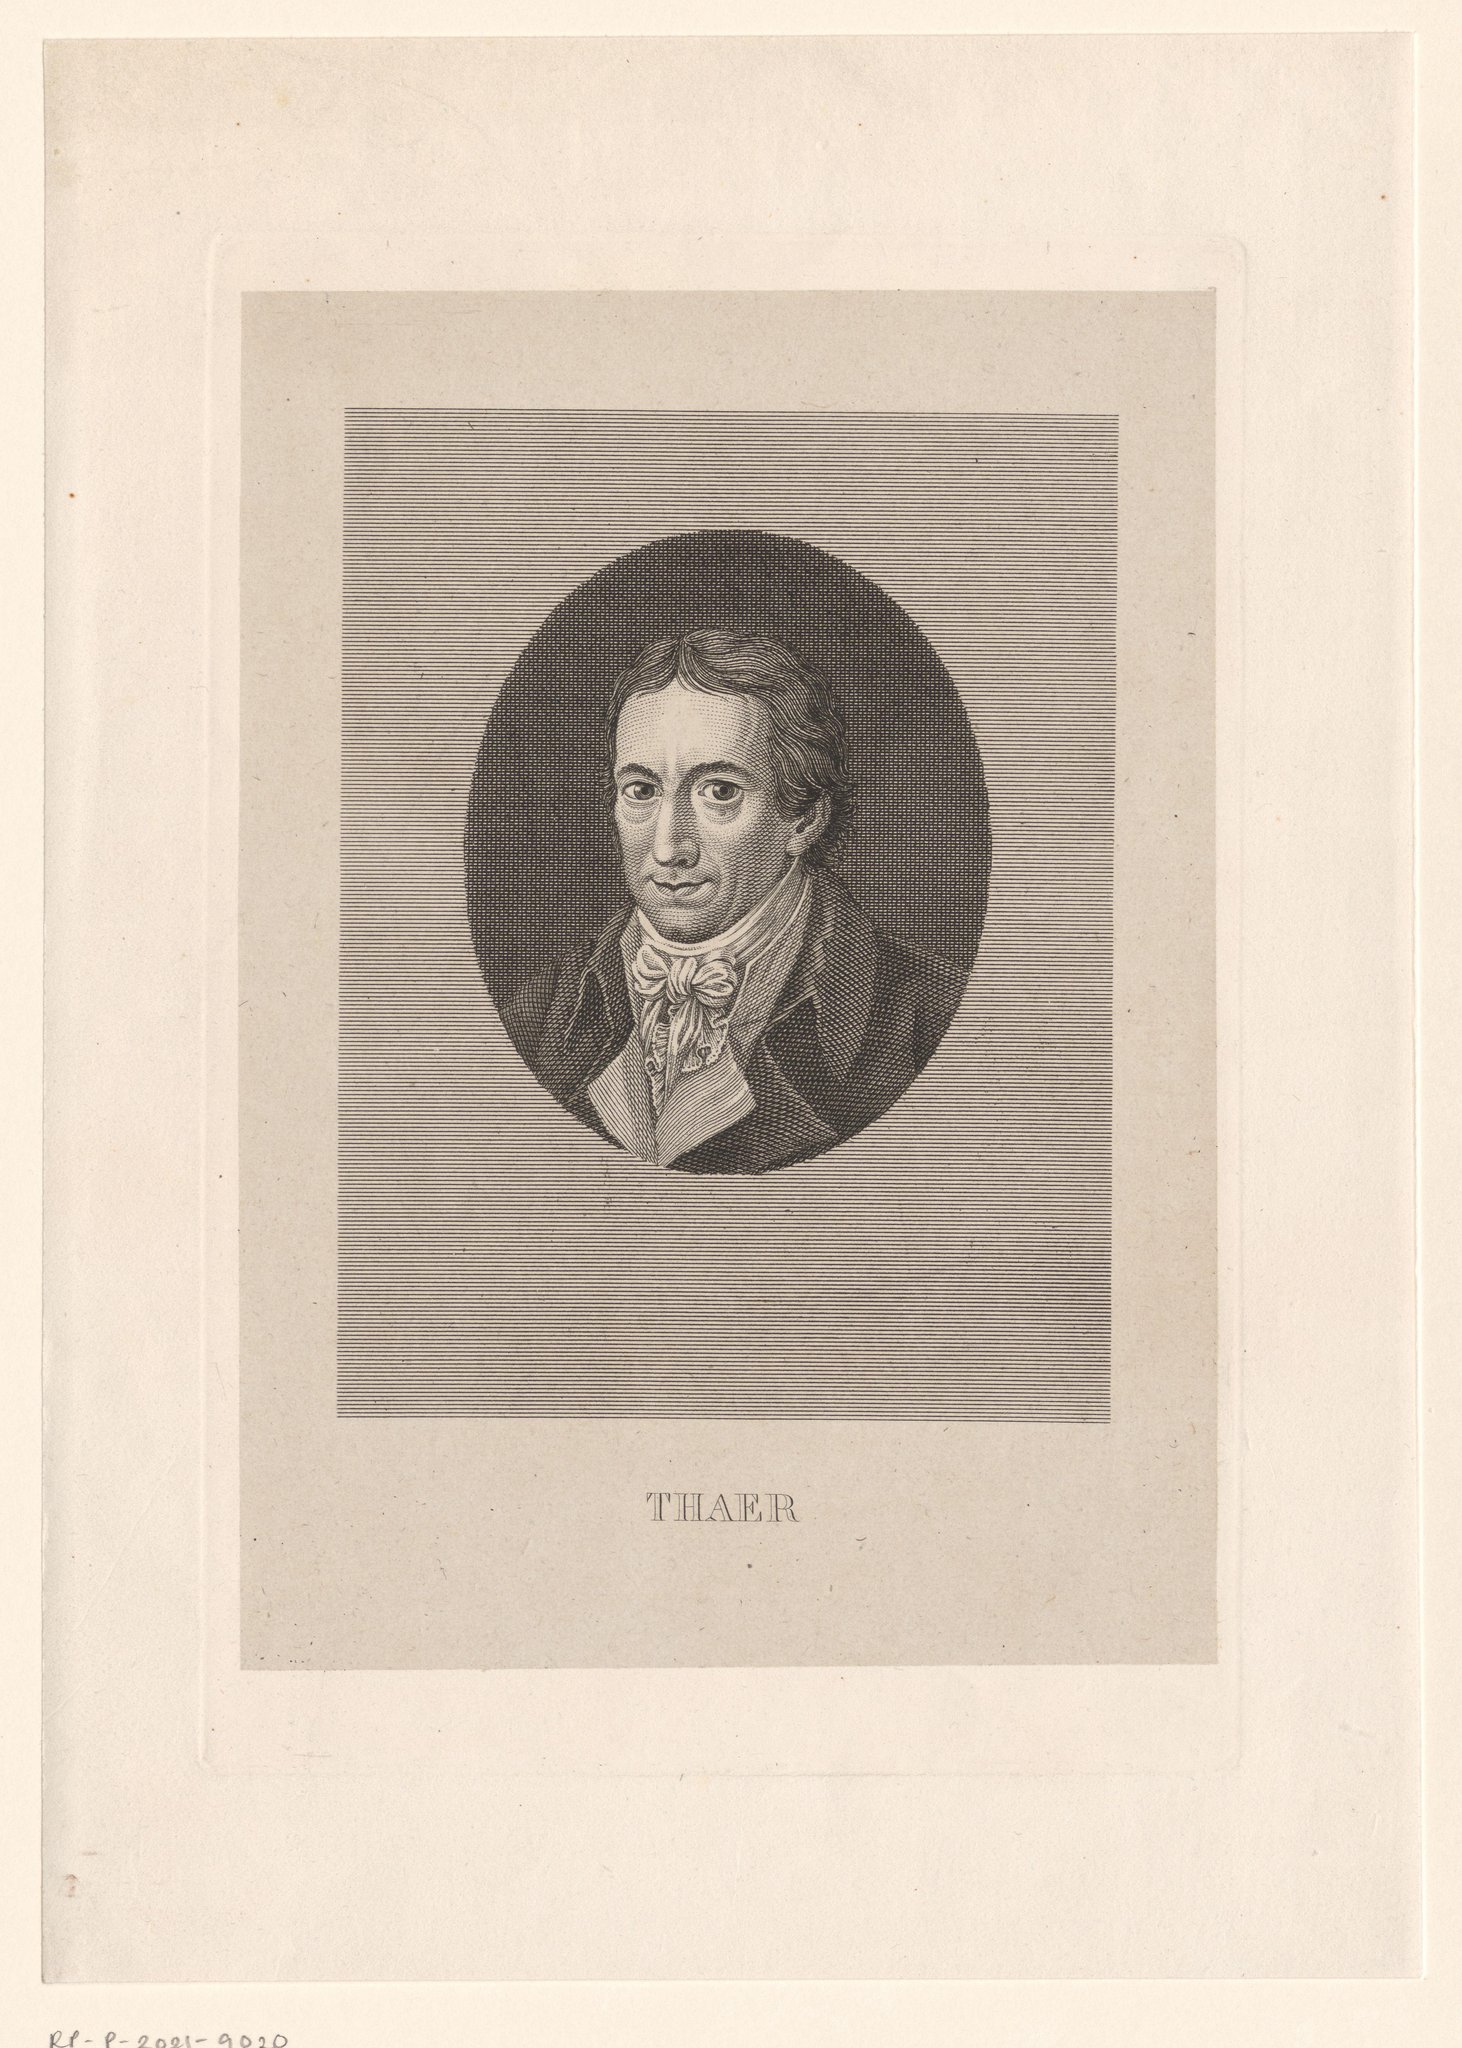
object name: print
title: Portret van Albrecht Daniel Thaer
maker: Anonymous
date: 1800-1849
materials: paper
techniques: etching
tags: albrecht daniel thaer, historical persons, physician, doctor